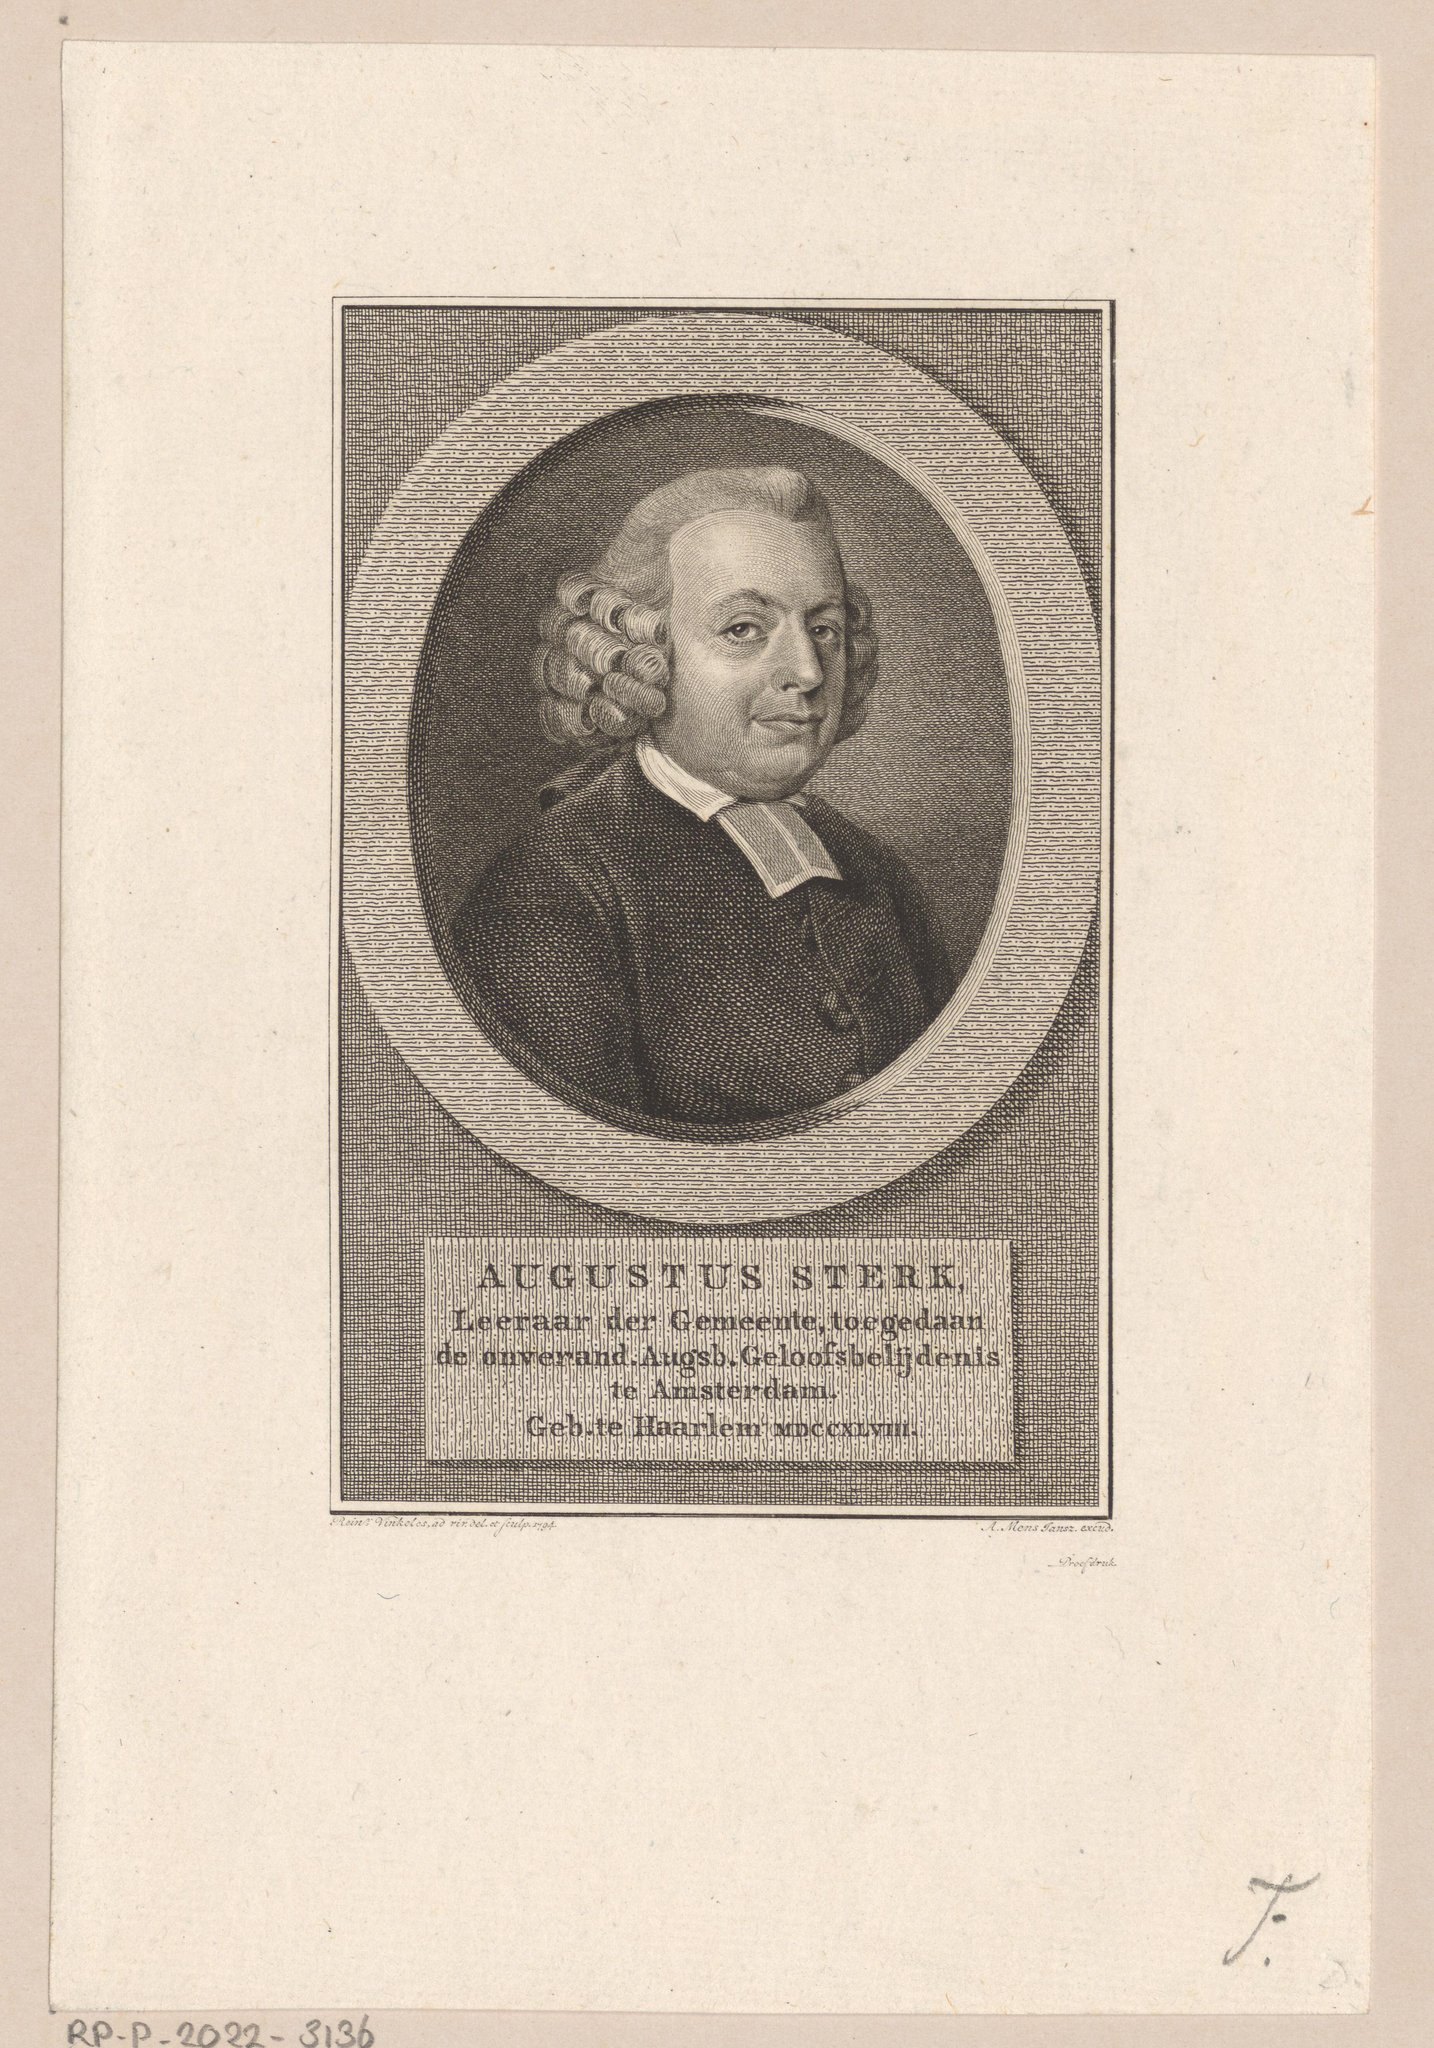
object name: print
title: Portret van Augustus Sterk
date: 1794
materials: paper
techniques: engraving, etching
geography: amsterdam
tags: haarlem, historical persons, functionaries and dignitaries (with name) ~ episcopal protestant churches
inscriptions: collector's mark: Lugt 240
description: Met vierregelig onderschrift in het Nederlands.